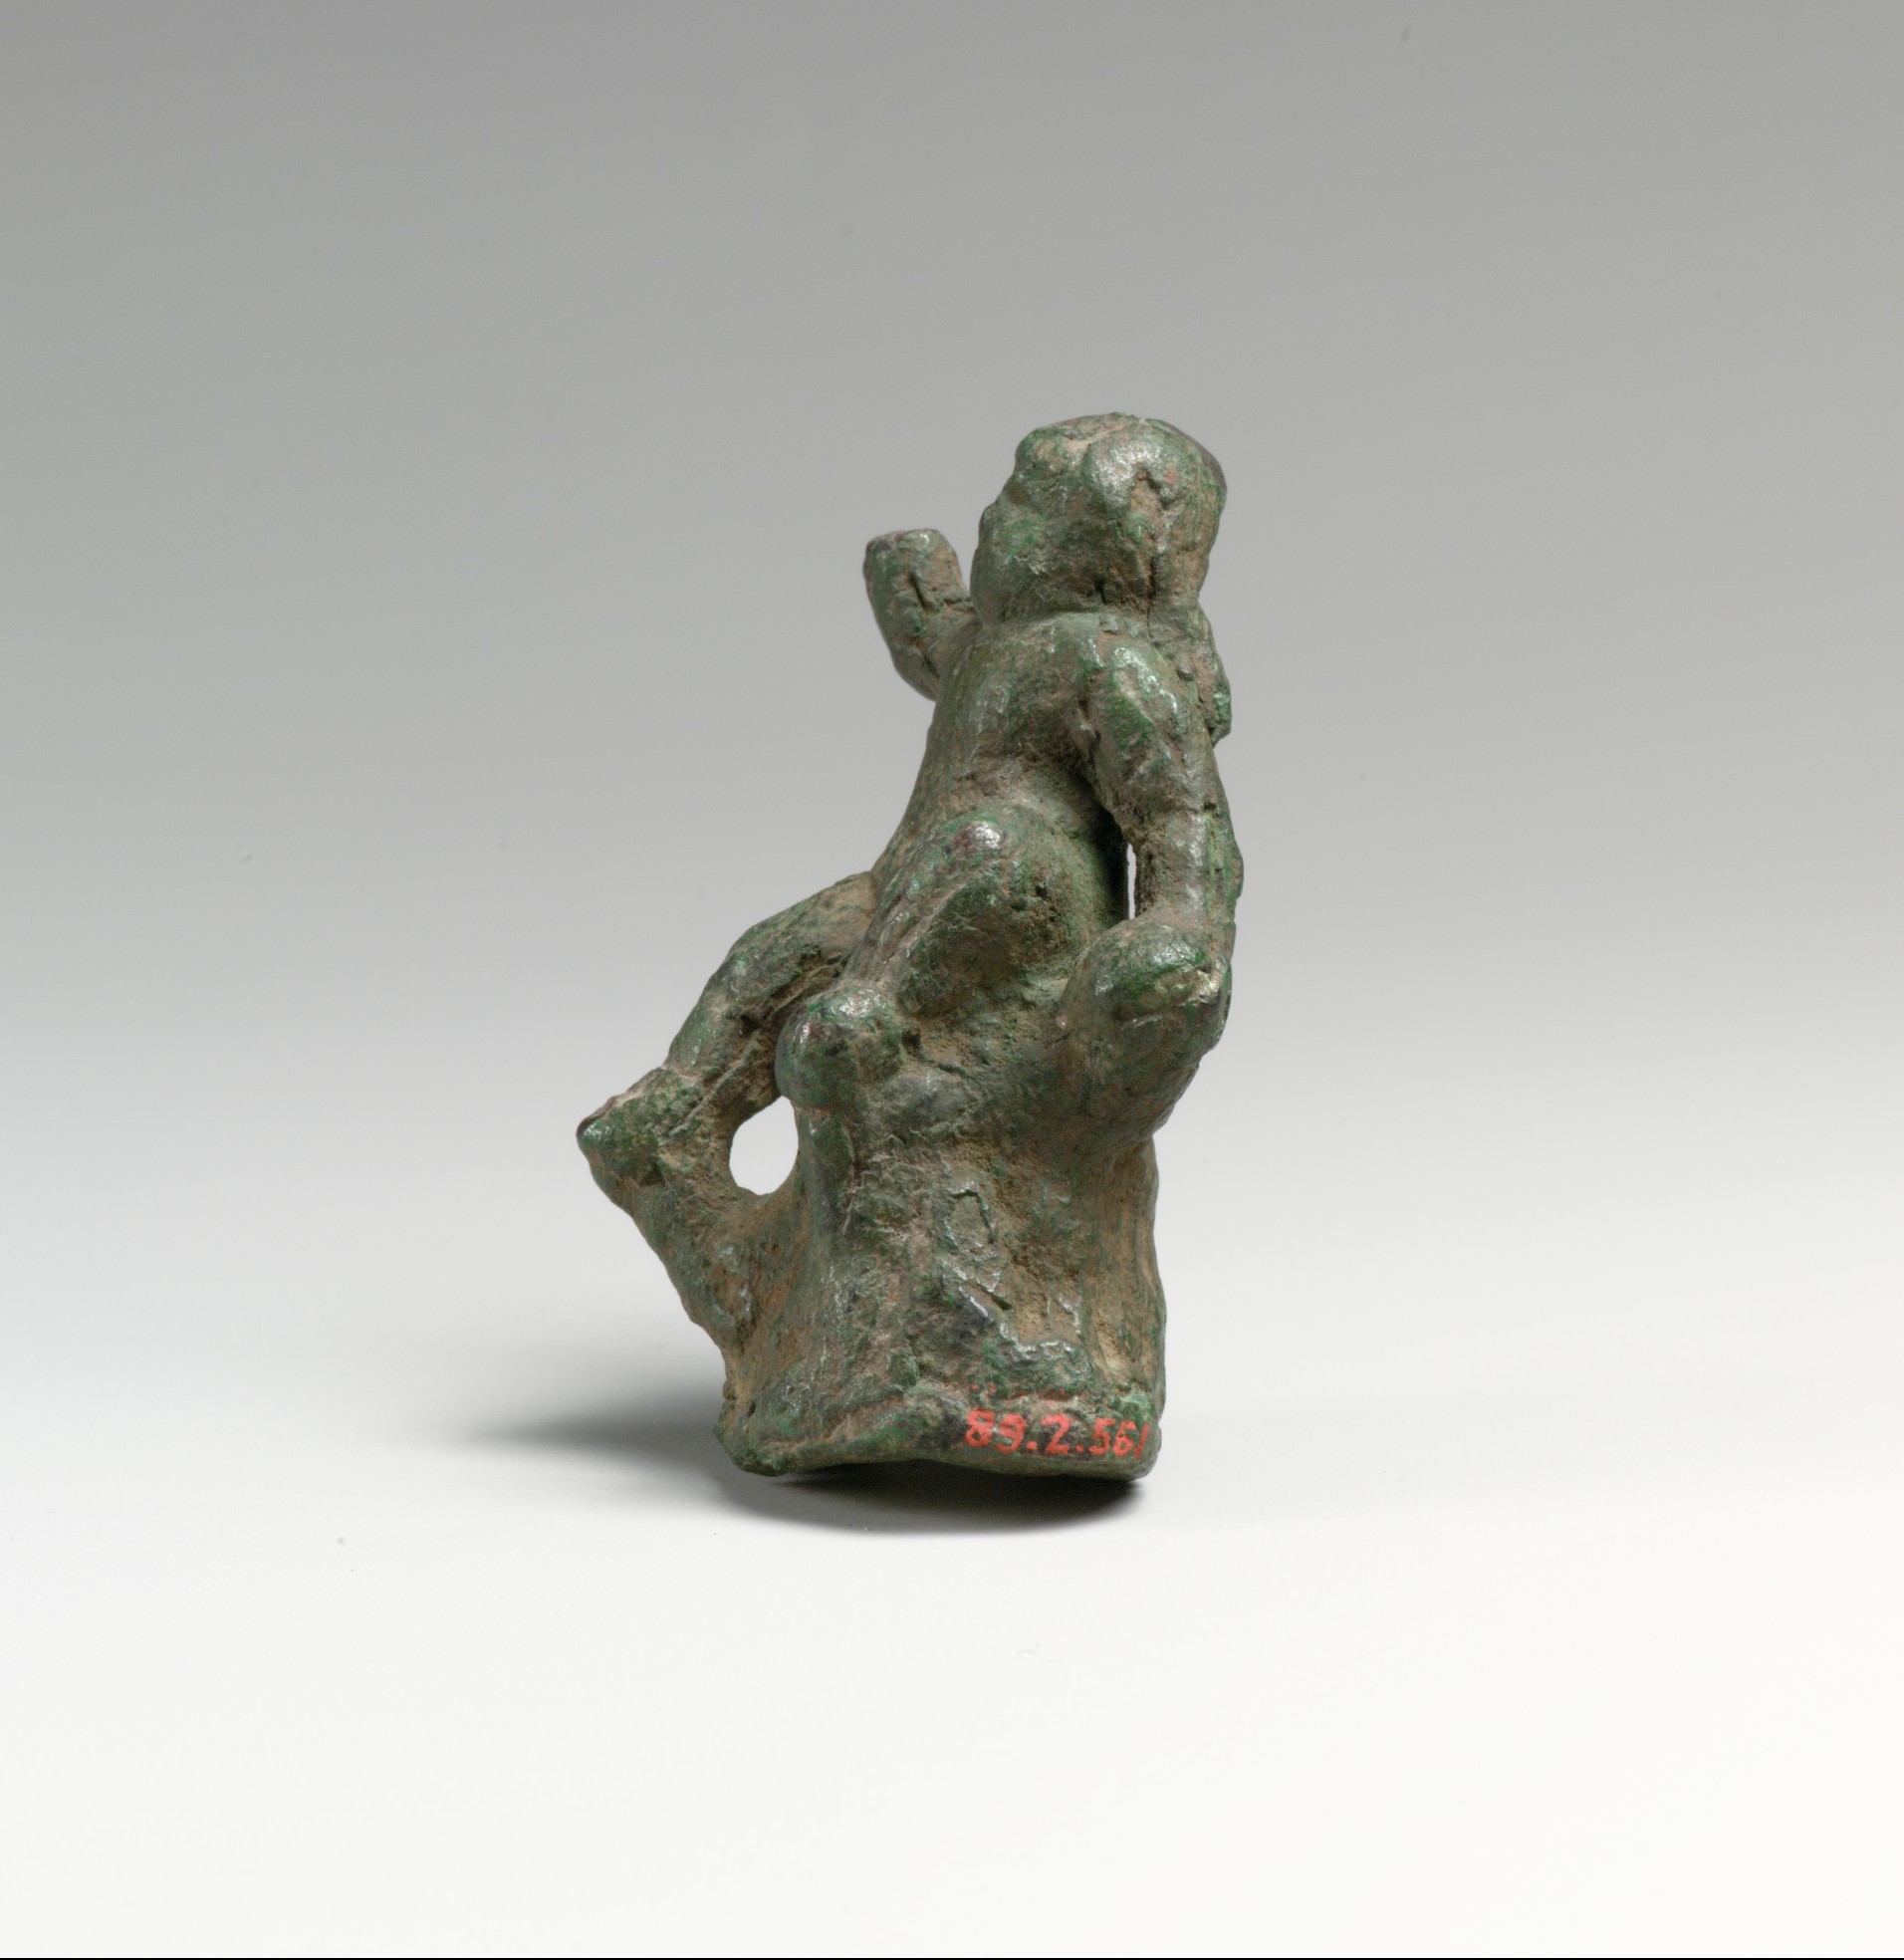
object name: statuette of eros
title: Bronze statuette of Eros seated on a rock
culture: greek or roman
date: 200 BCE-200 CE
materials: bronze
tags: eros